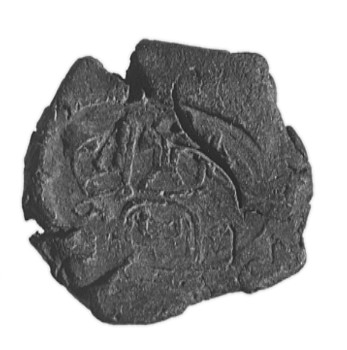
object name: sealing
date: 2030-1640 BCE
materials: clay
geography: egypt